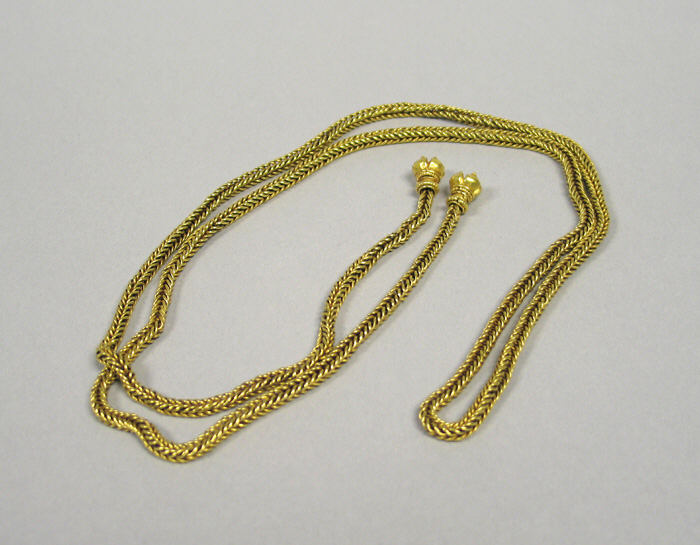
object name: chain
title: Braided Chain with Lotus-Shaped Finials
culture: indonesian, javanese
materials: gold